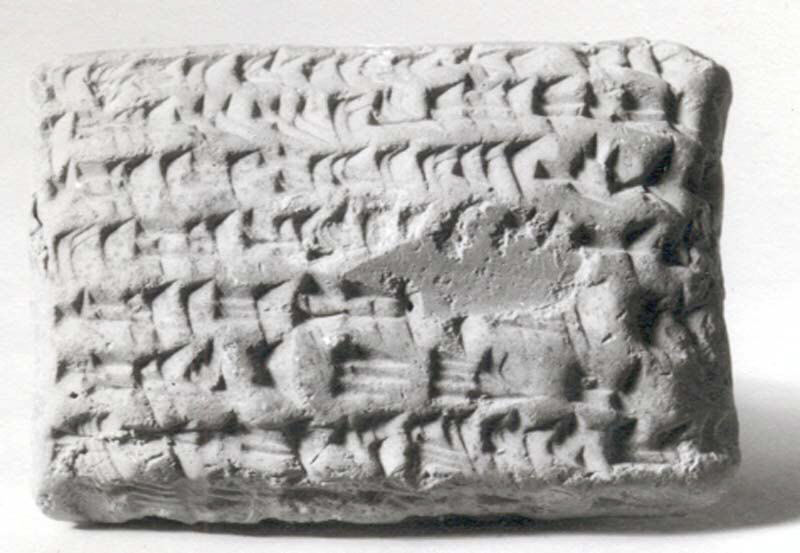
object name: cuneiform tablet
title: Cuneiform tablet: promissory note for silver, Esagilaya archive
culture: babylonian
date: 601 BCE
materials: clay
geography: mesopotamia